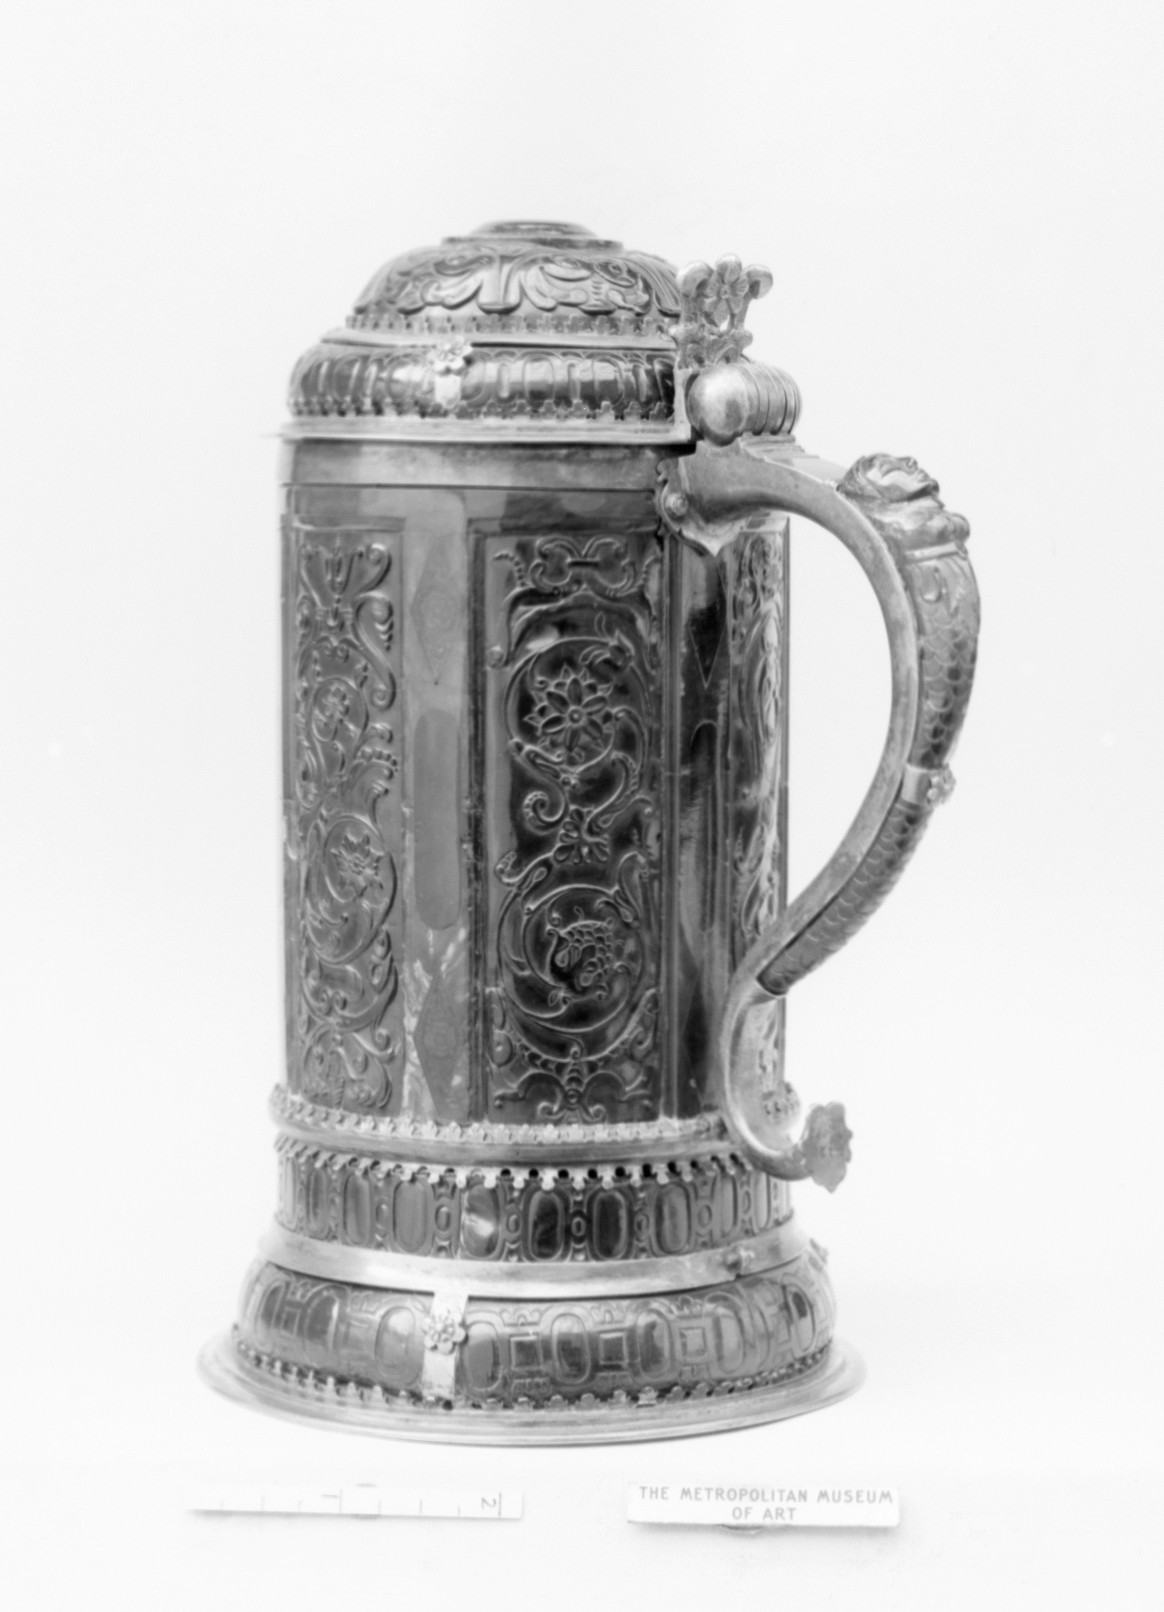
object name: tankard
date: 1601-1650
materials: amber, ivory, mica, silver gilt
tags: faces,flowers